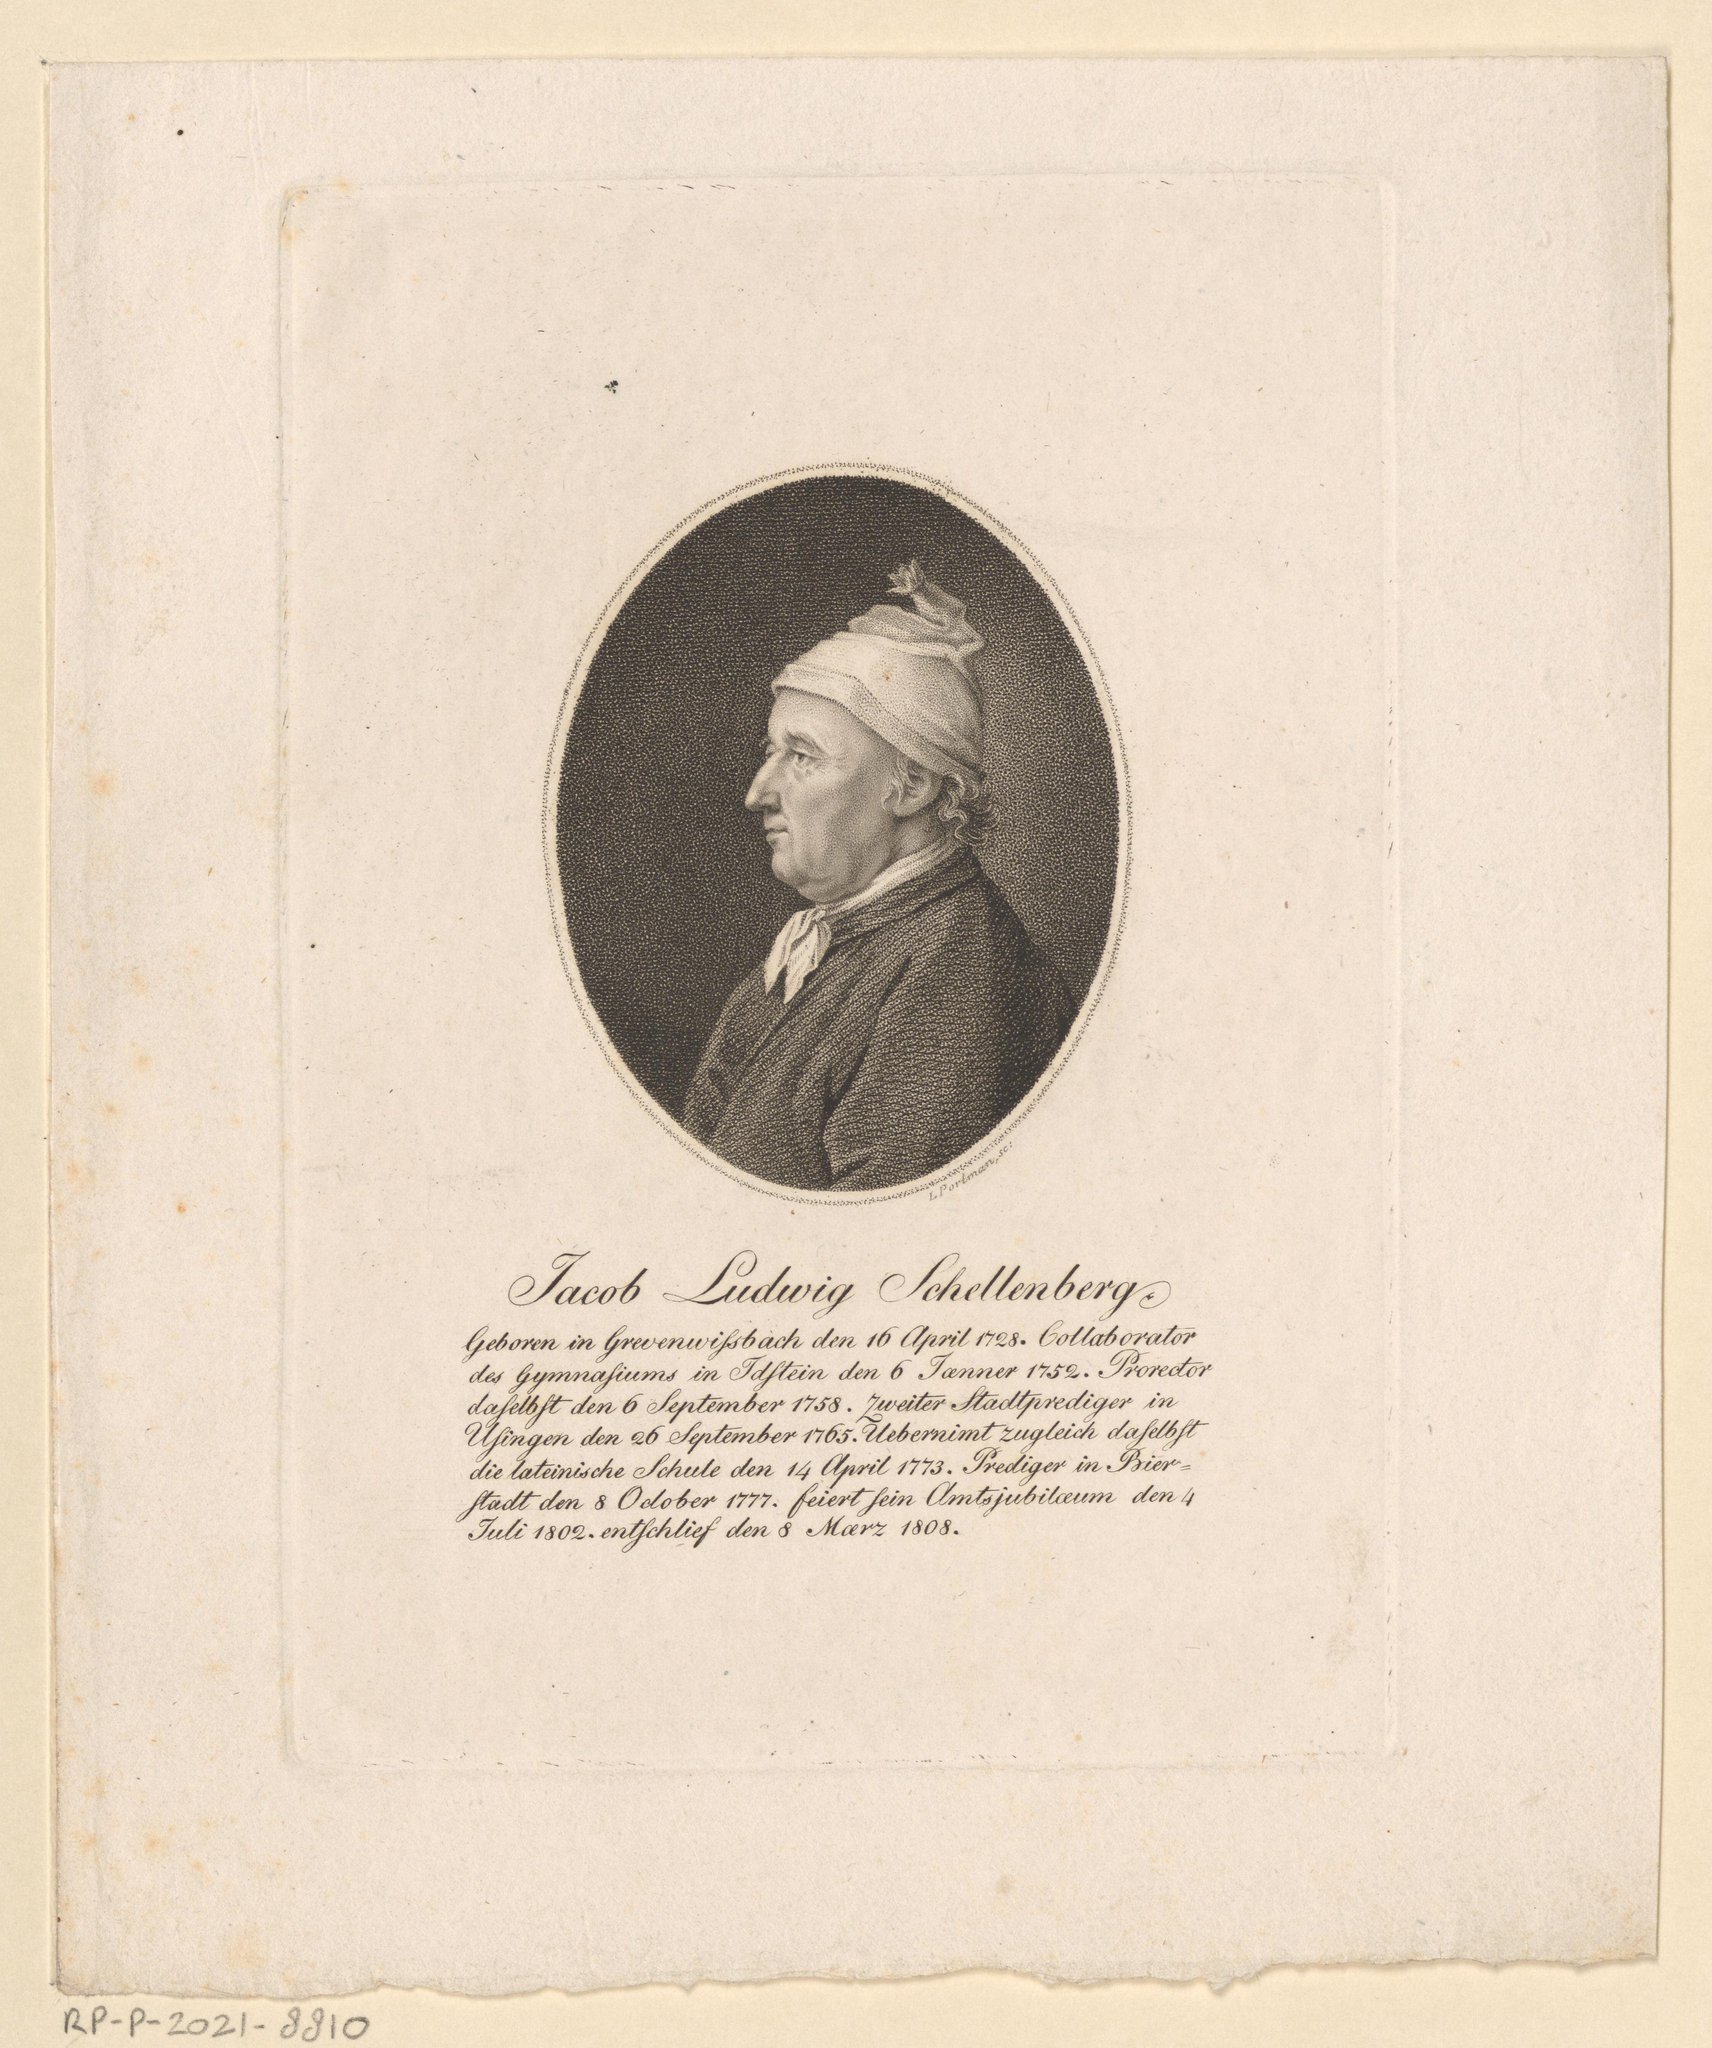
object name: print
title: Portret van Jakob Schellenberg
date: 1808-1828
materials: paper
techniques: engraving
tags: historical persons, head-gear: hat